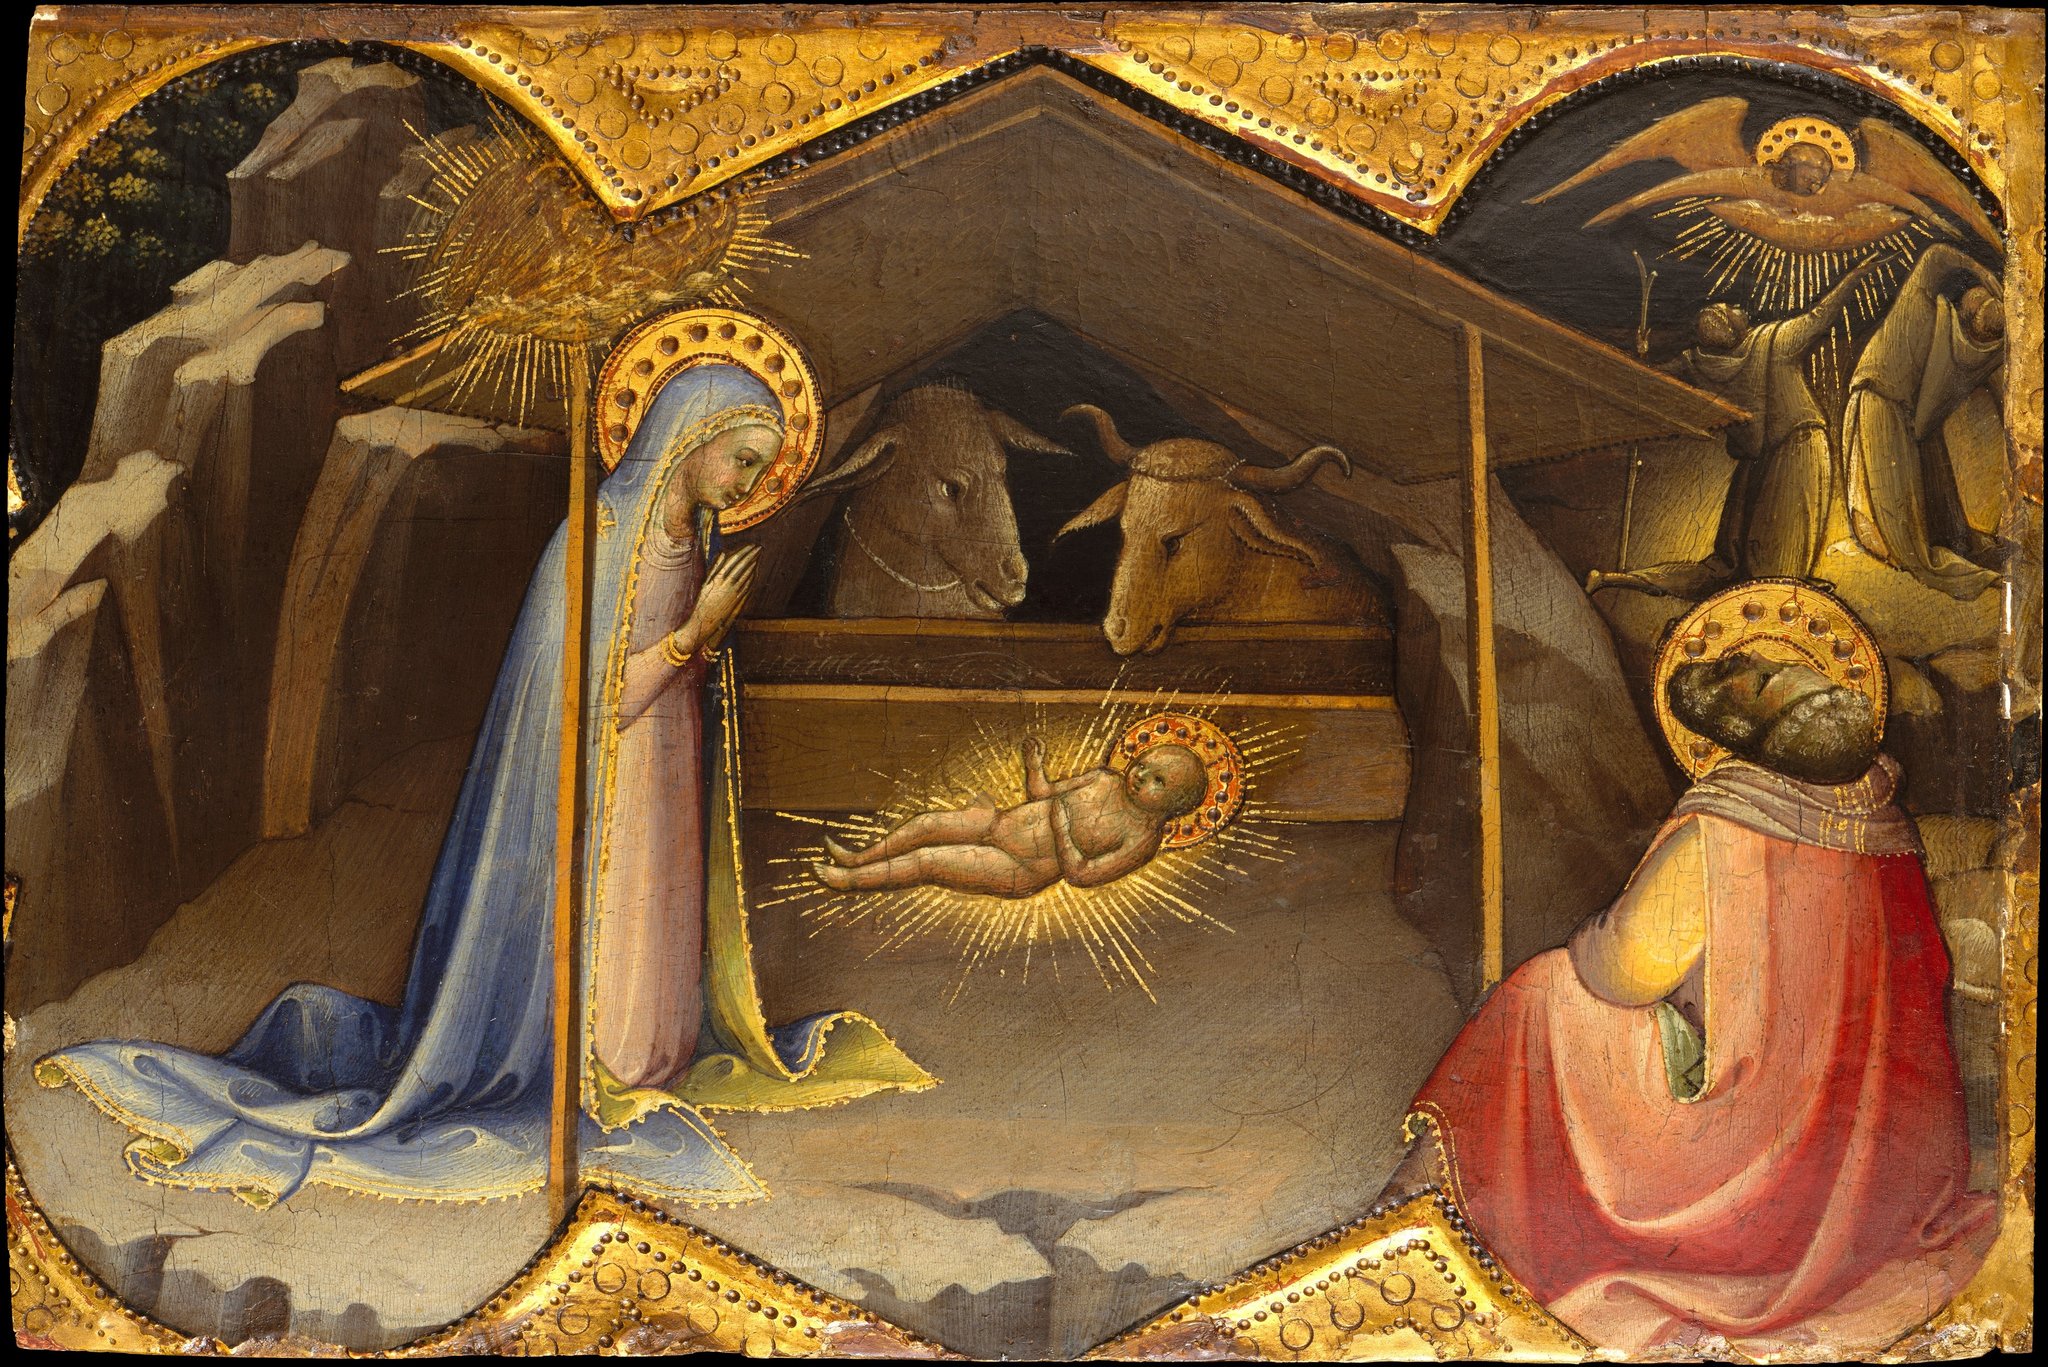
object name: painting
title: The Nativity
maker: lorenzo monaco (piero di giovanni)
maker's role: artist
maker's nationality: italian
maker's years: 1370-1425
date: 1406-1410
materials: gold leaf, paint, wood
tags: holy family,nativity